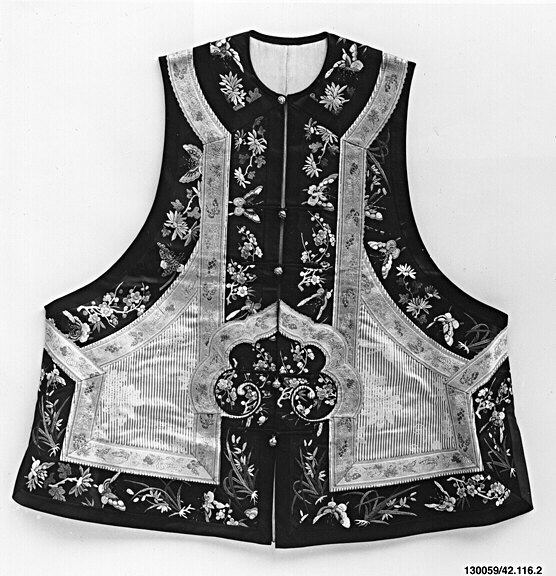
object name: woman's vest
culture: chinese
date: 1867-1933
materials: silk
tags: butterflies,flowers